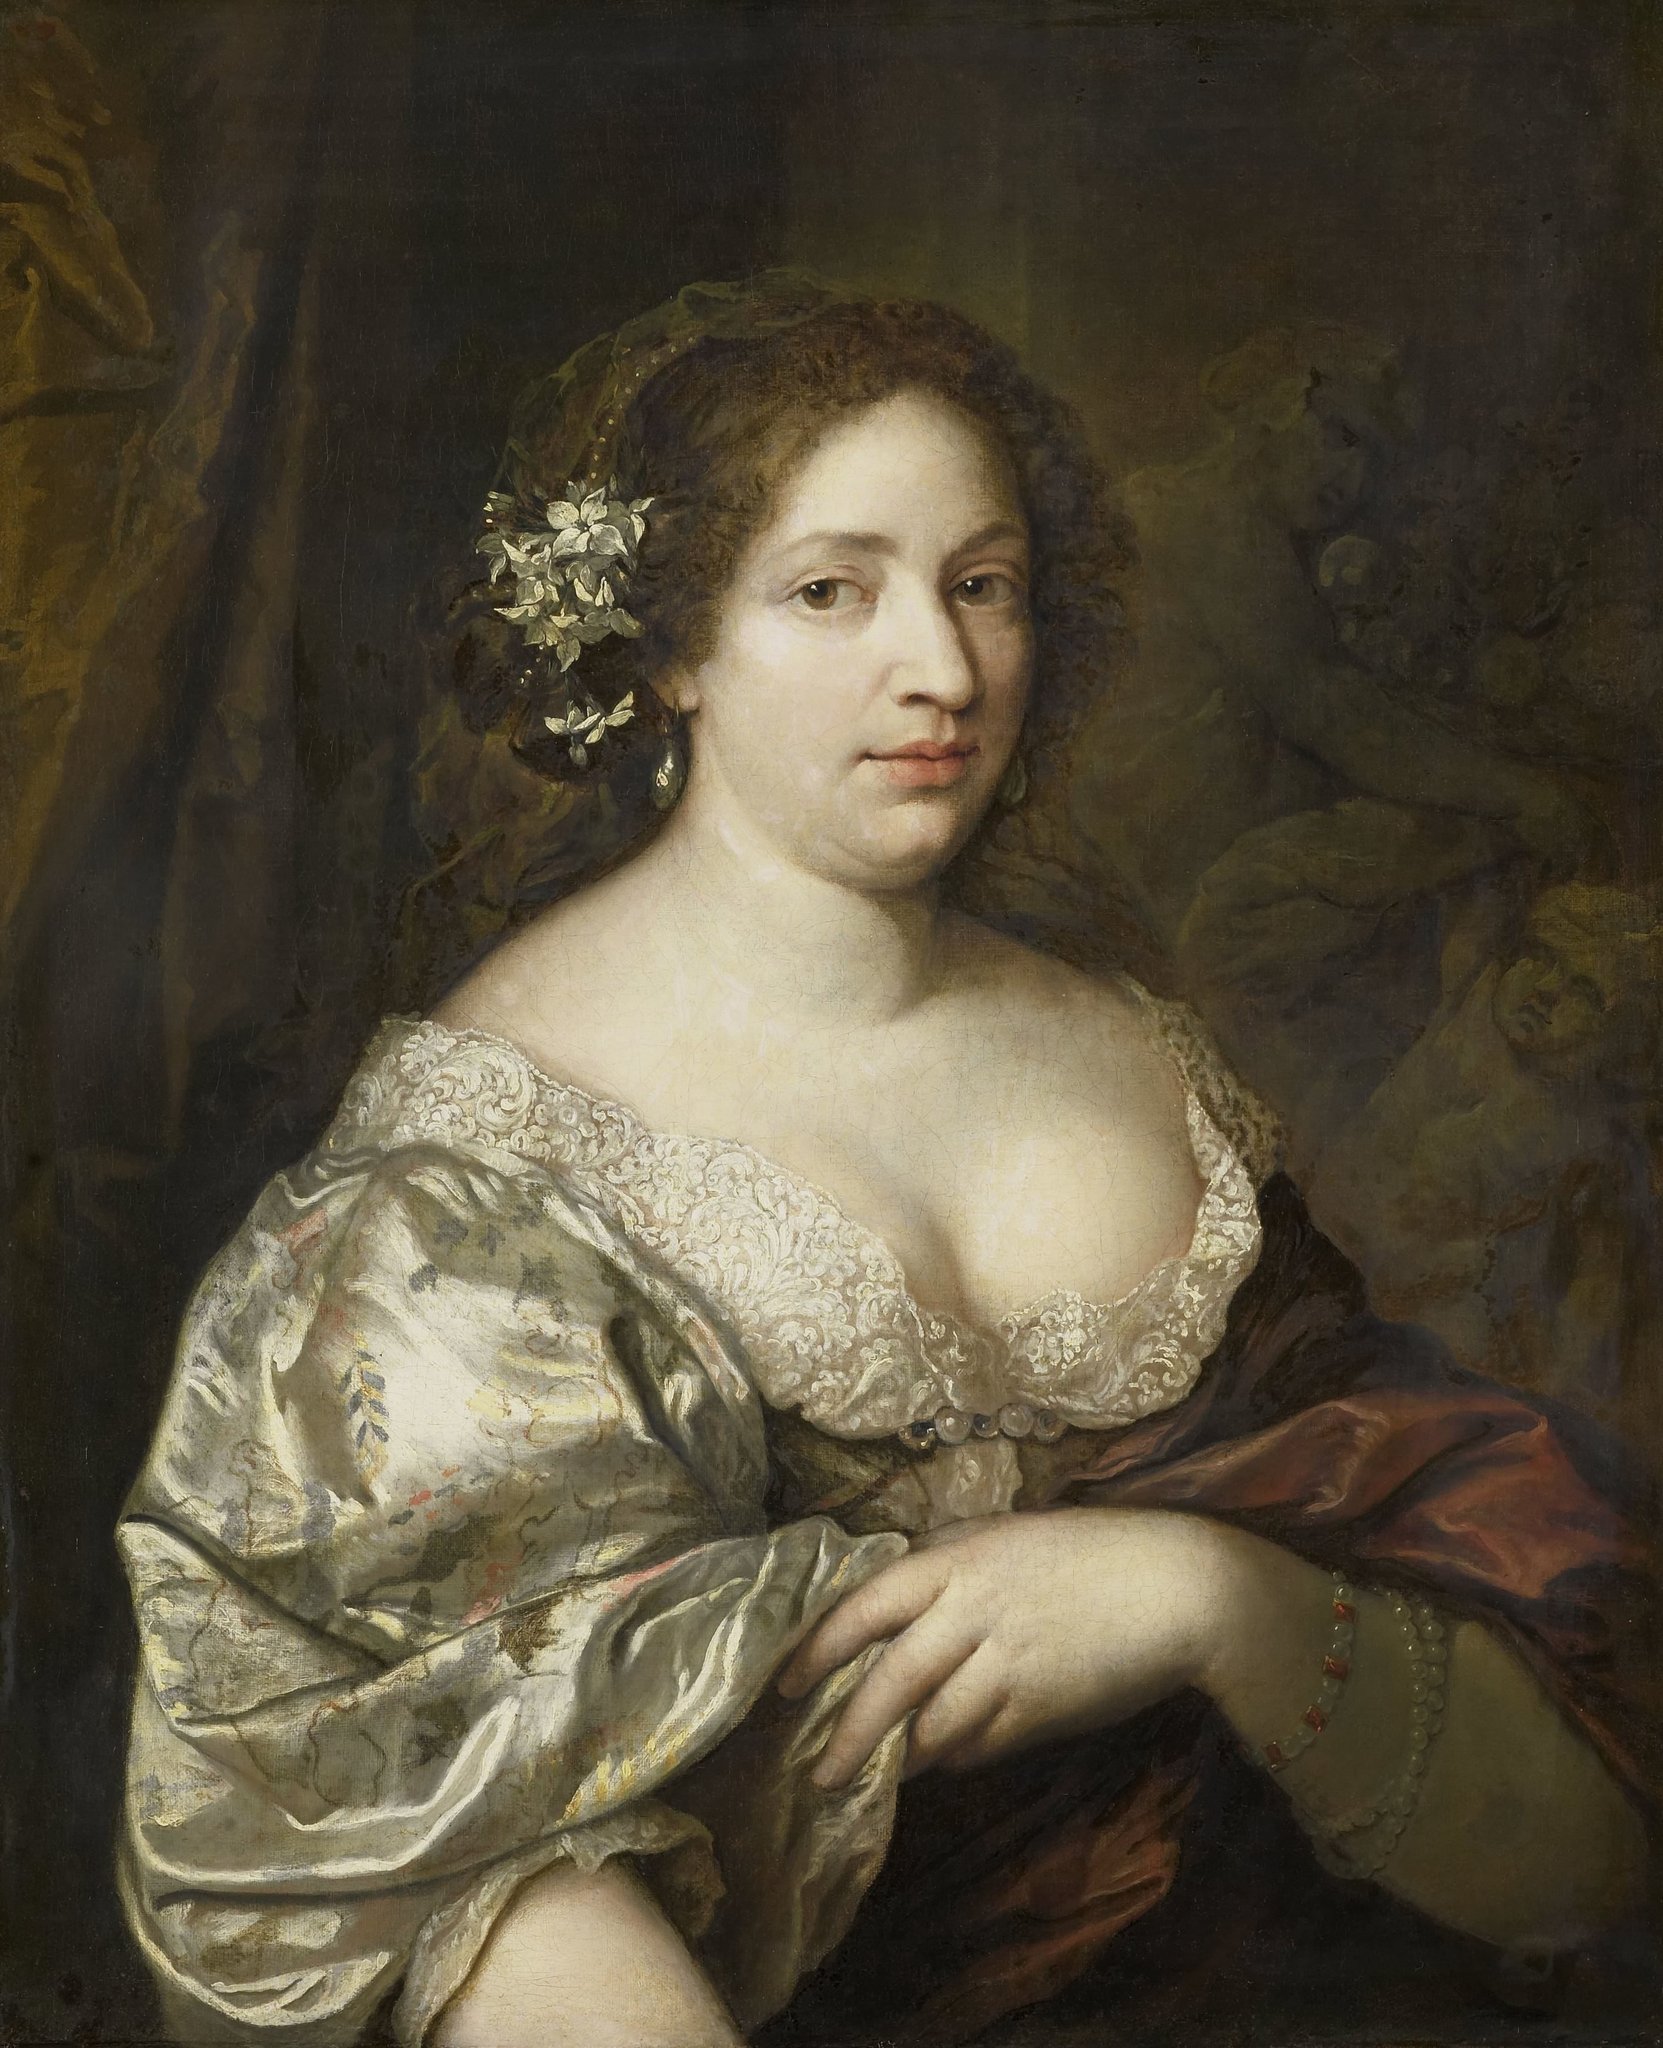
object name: painting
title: Portrait of Margaretha Godin (d. 1694), wife of the artist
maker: caspar netscher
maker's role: draughtsman, painter, print maker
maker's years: 1639-1684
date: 1660-1684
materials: canvas, oil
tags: historical persons - bb - woman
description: Portret van Margaretha Godin, echtgenote van de schilder. Ten halven lijve, zittend naar rechts, met bloemen in de haar. Op de achtergrond een voorstelling van een vrouw met een kind.